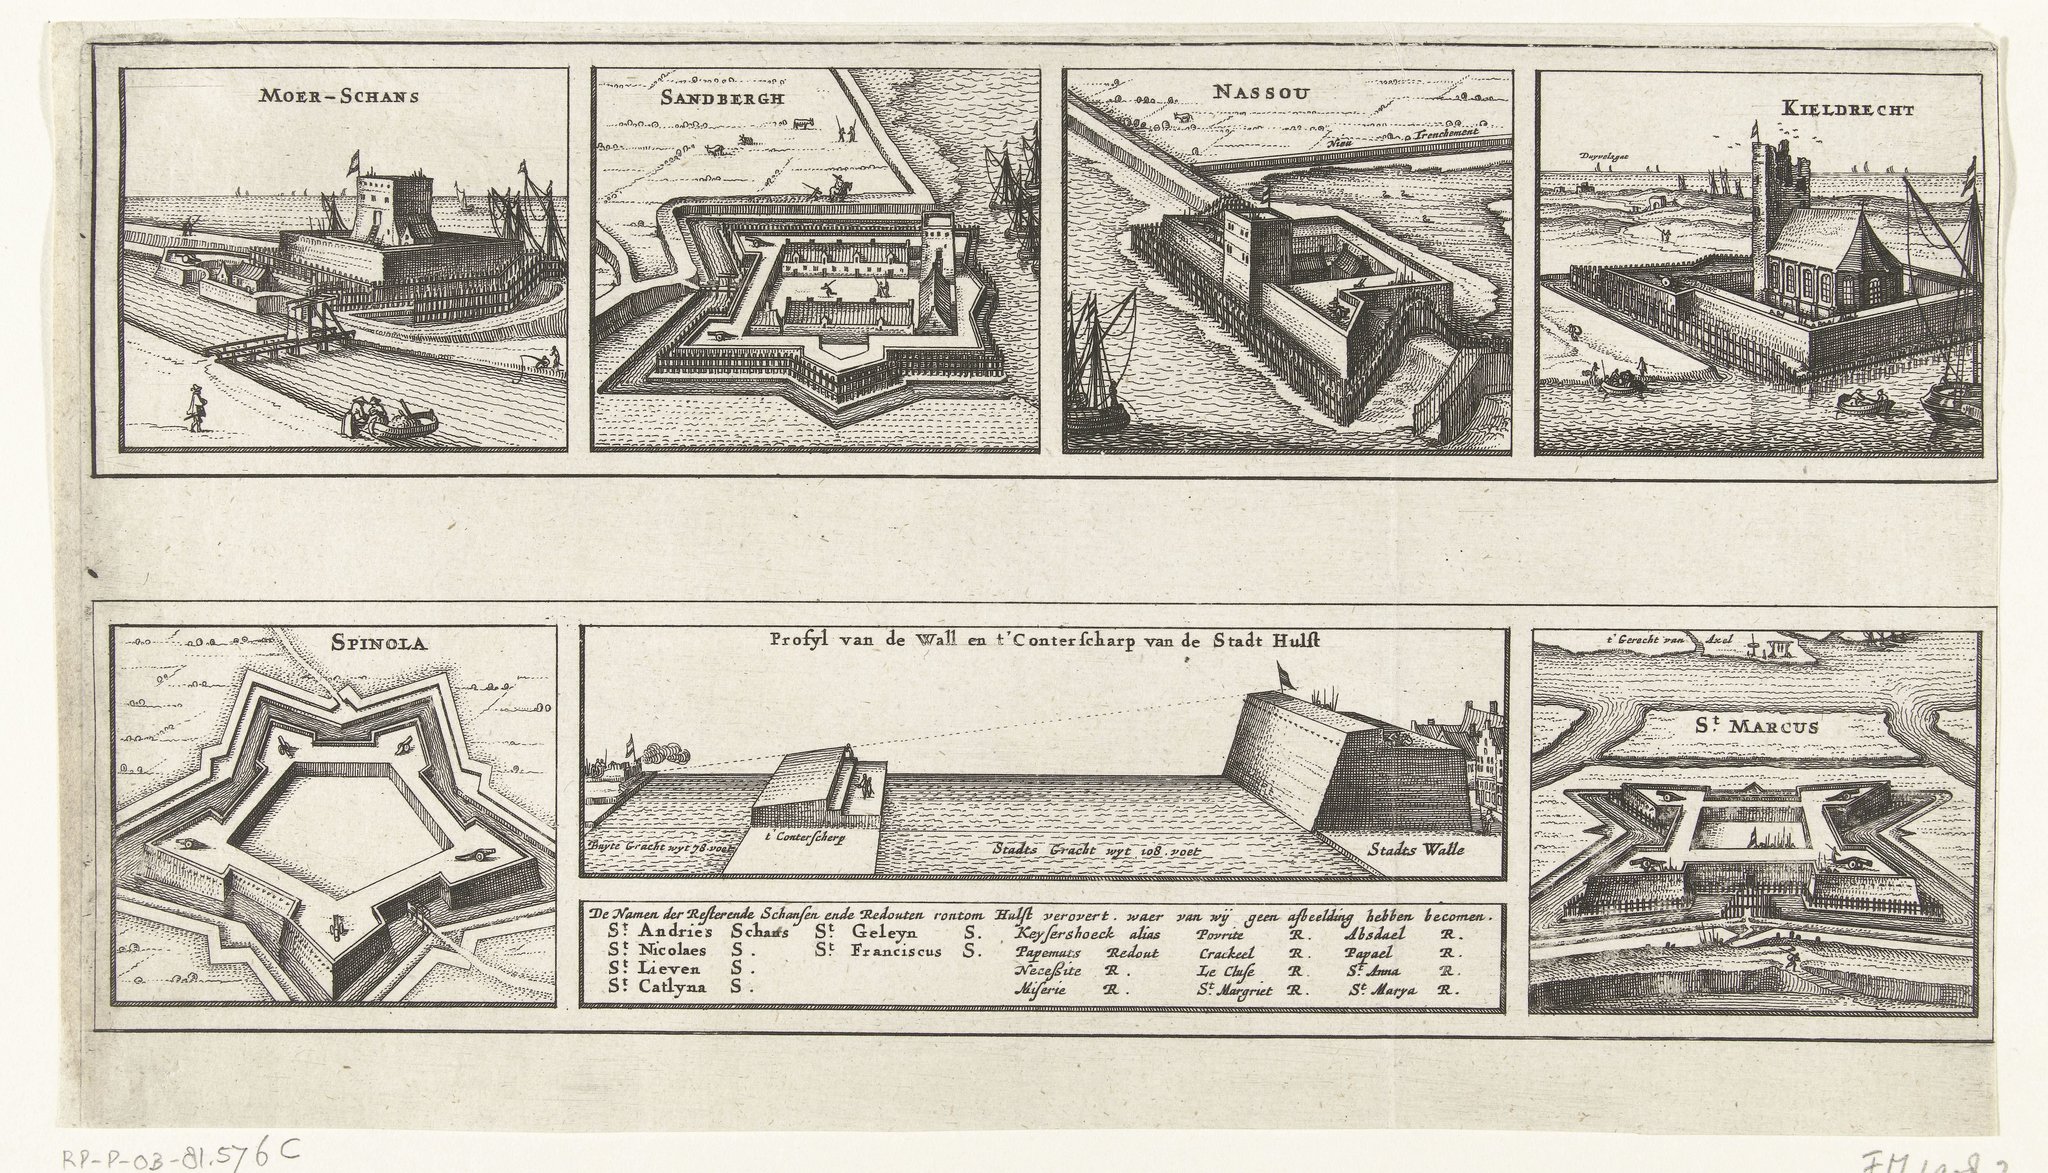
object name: print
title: Zes forten bij Hulst, 1645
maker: claes jansz. visscher (ii)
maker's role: draughtsman, print maker, publisher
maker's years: 1586-1652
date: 1645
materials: paper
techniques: etching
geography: amsterdam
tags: the hague, frederick henry (prince of orange), fortress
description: Zes forten bij Hulst, belegerd door het Staatse leger onder Frederik Hendrik van 28 september tot 5 november 1645. Blad met boven een strook met vier afzonderlijke afbeeldingen van forten, onder een strook met twee forten en in het midden een doorsnede van de stadsgracht en wal van Hulst. Wellicht onderdeel van een ongemonteerd ensemble bestaande uit de twee kaarten, het profiel, het blad met de zes forten, de drie bladen van de uittocht van het garnizoen en de twee tekstbladen.